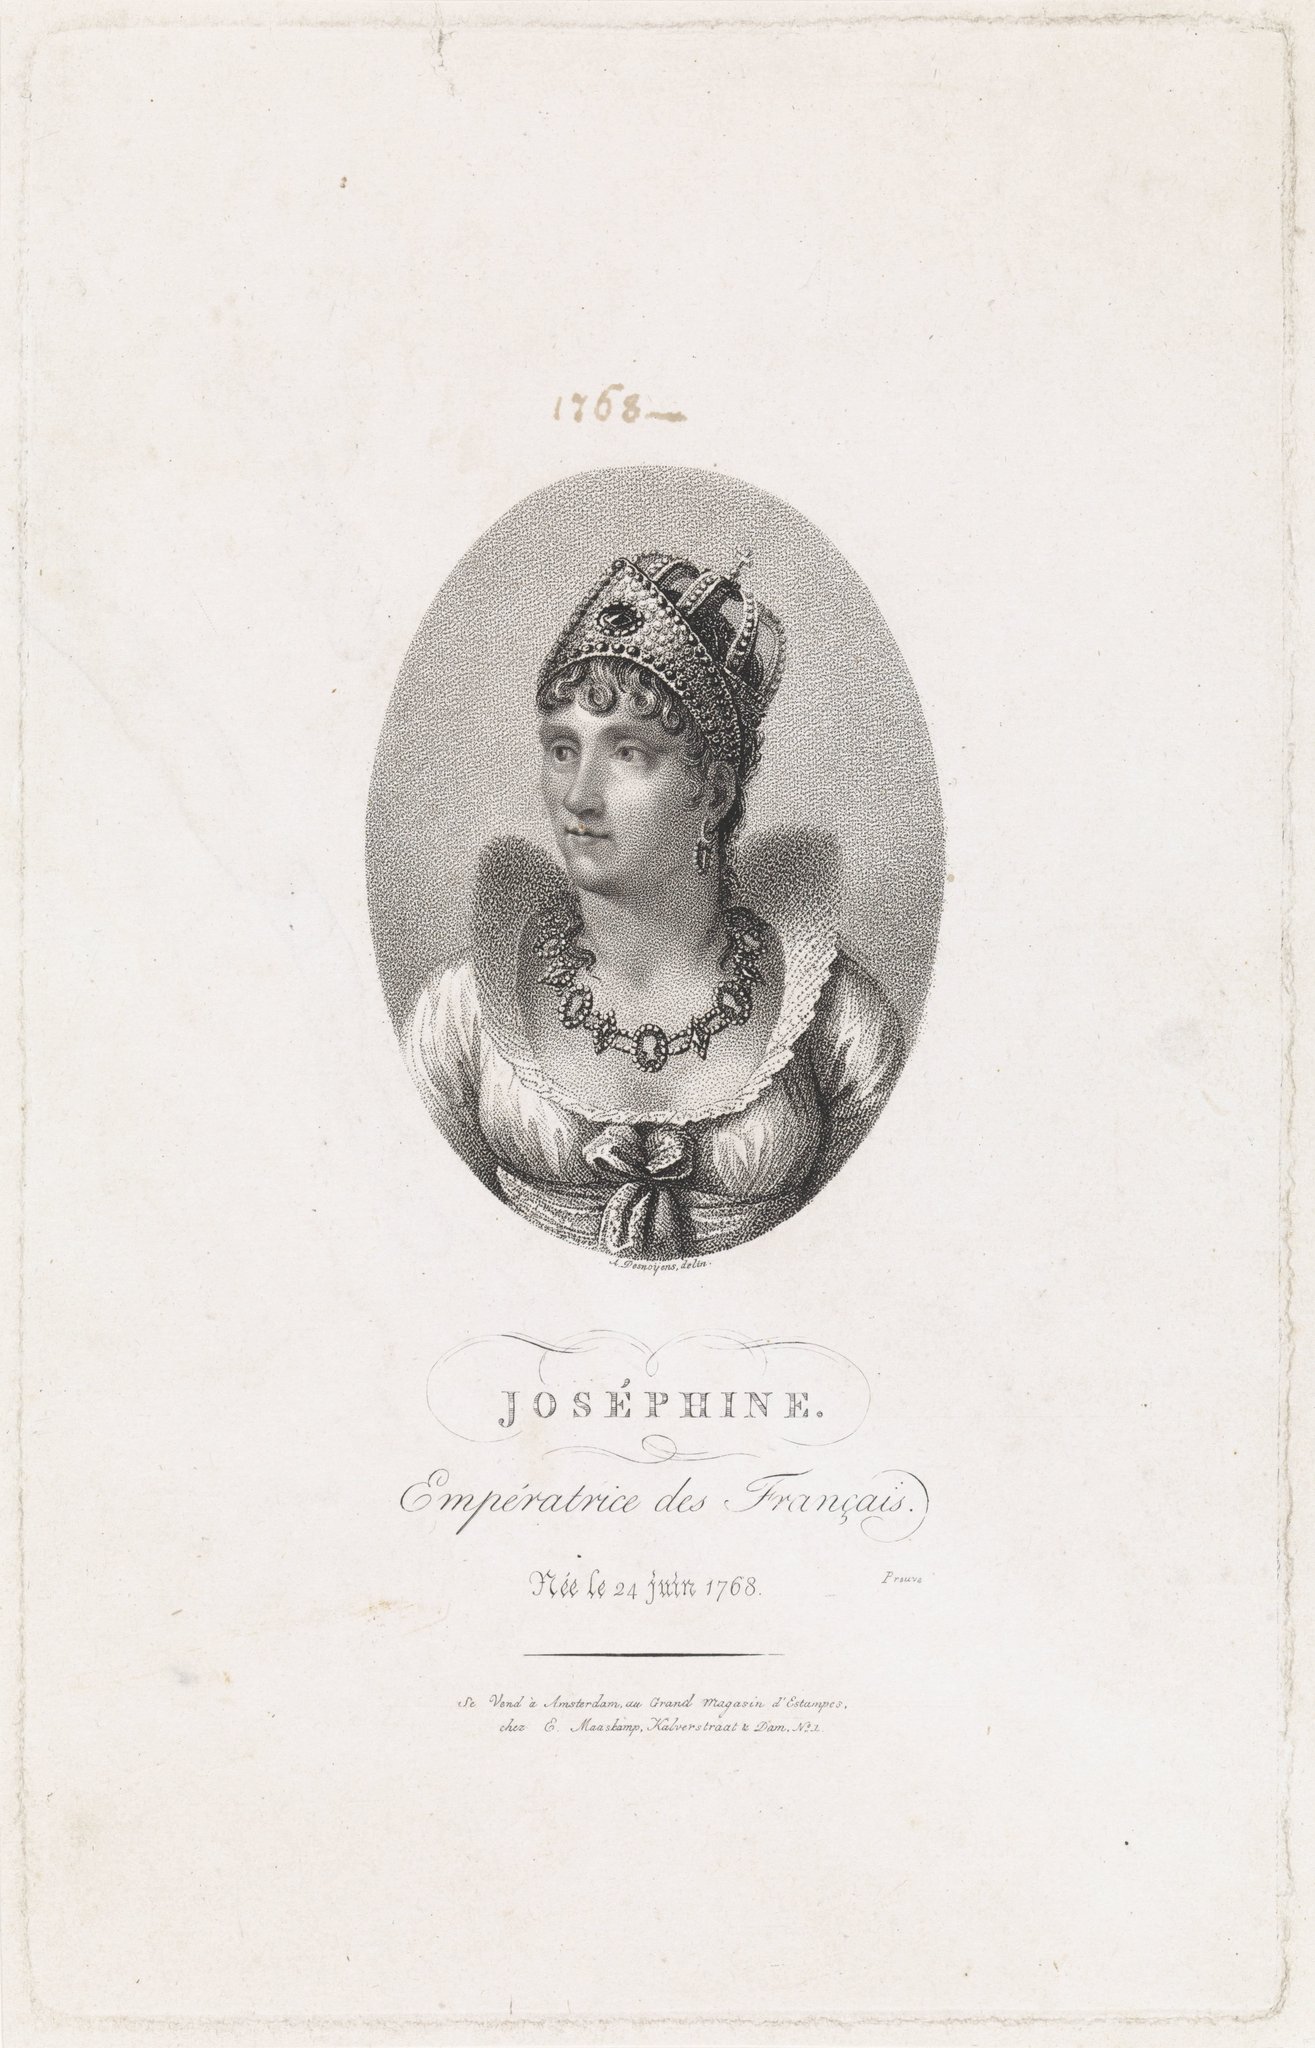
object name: print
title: Portret van Joséphine, keizerin van Frankrijk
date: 1794-1828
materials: paper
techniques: stippled etching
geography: amsterdam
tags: joséphine de beauharnais, crown (symbol of sovereignty) - bb - female ruler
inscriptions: date: ‘1768_’, collector's mark: Lugt 2228